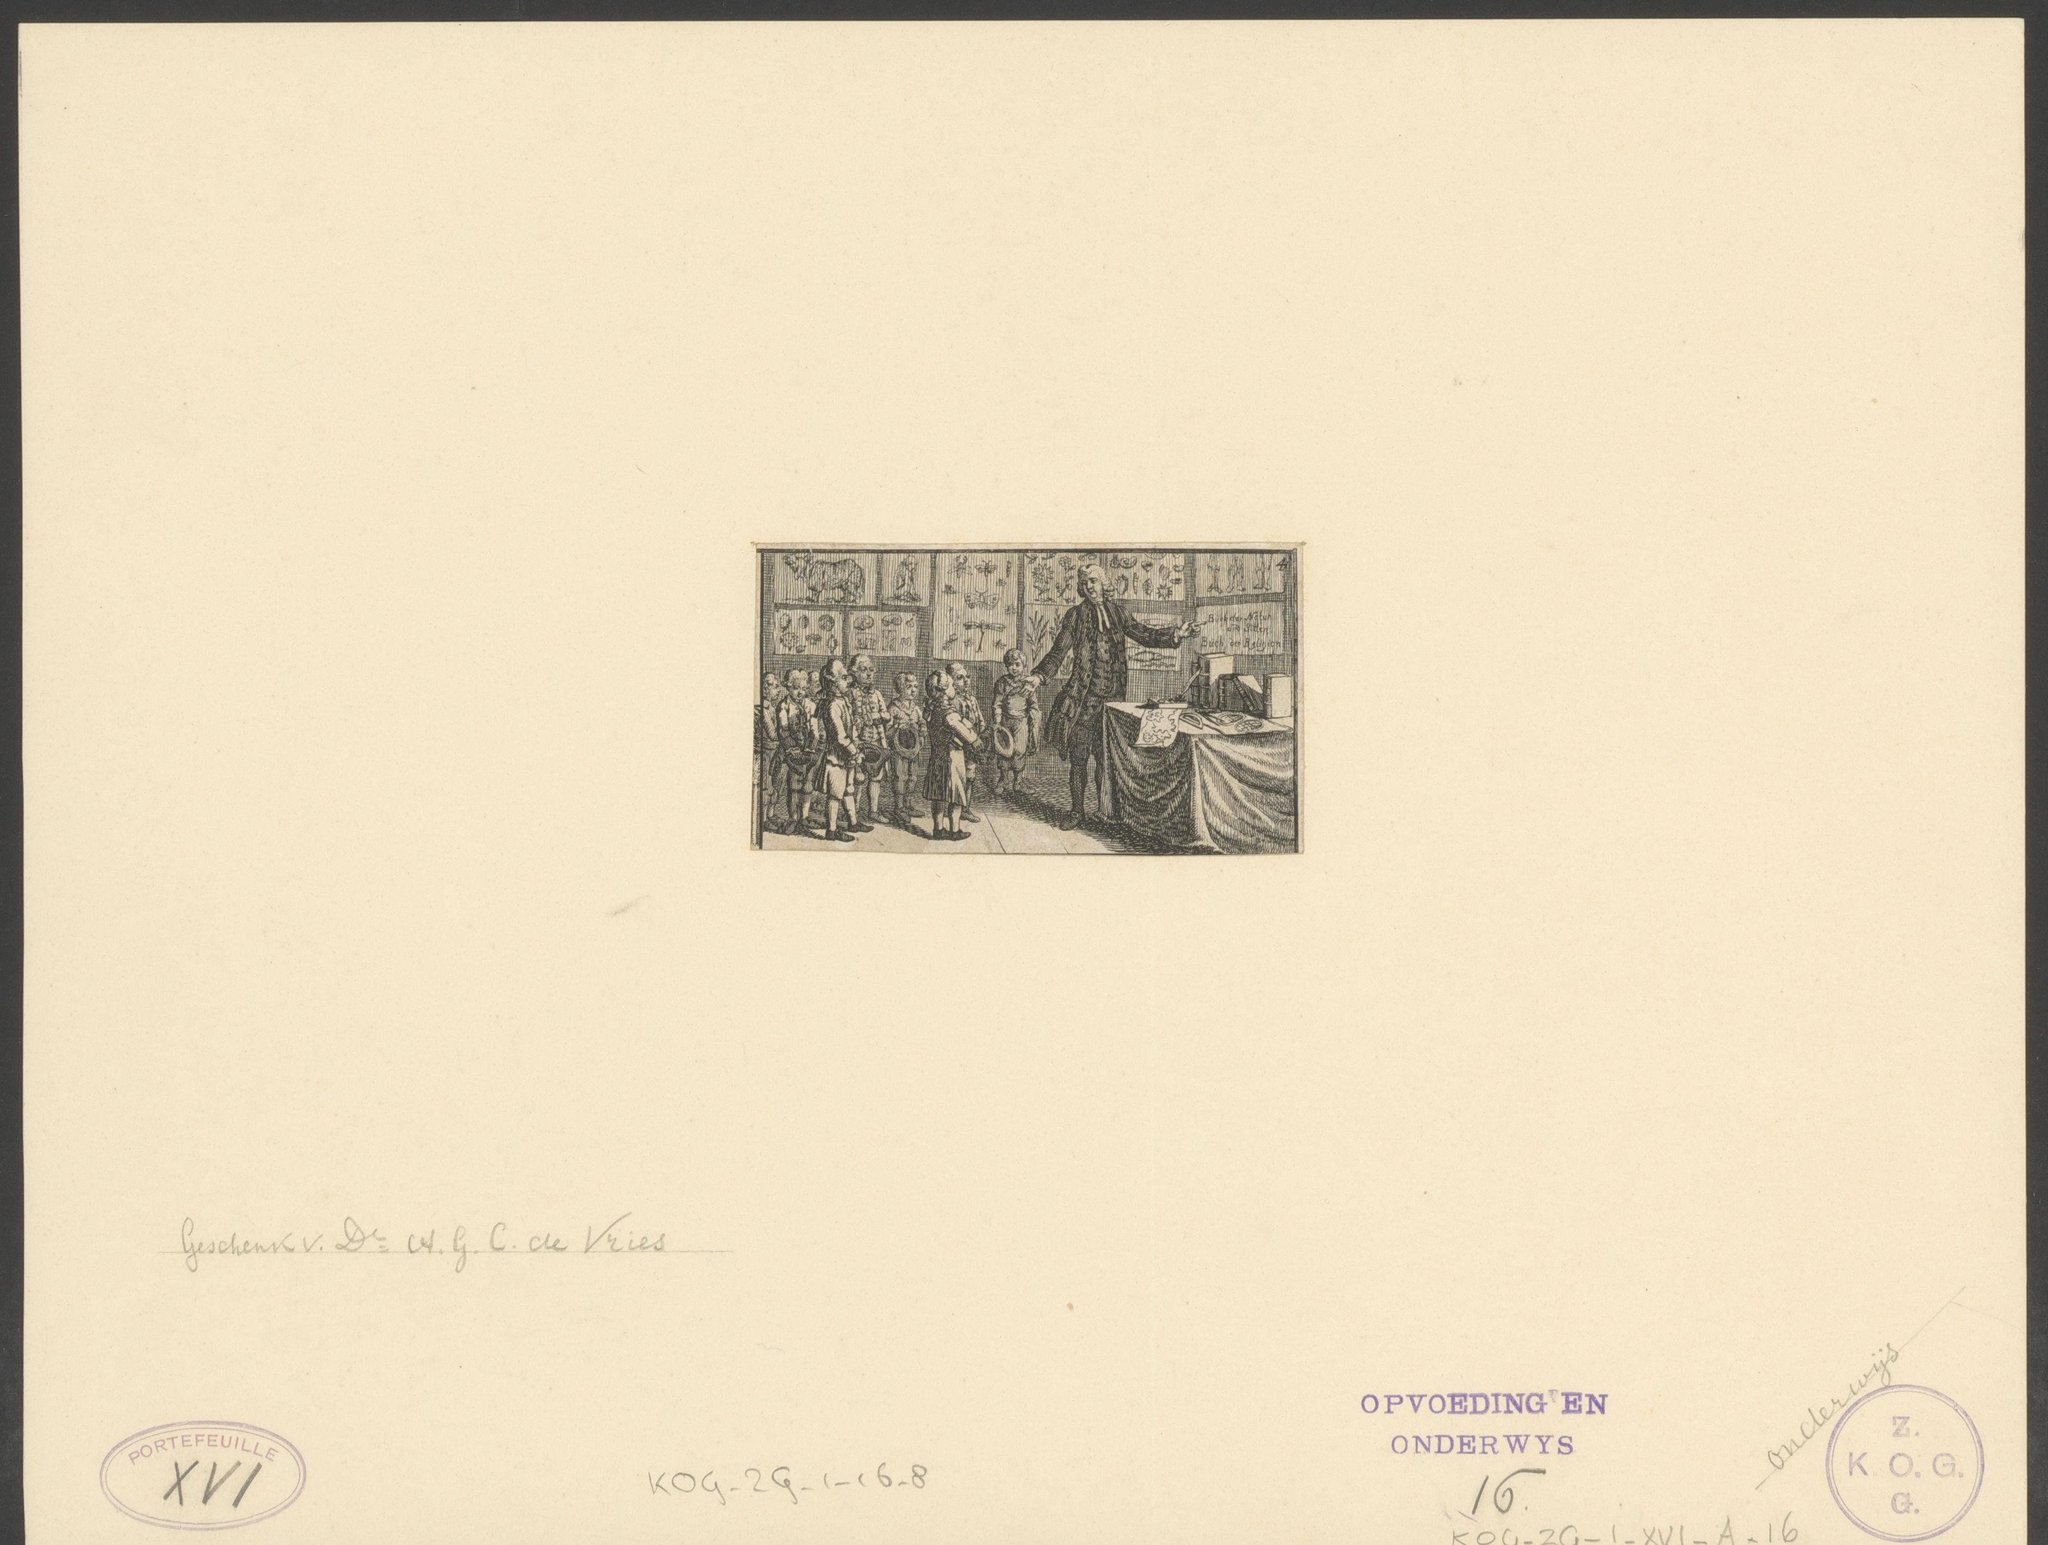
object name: print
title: Schoolmeester tijdens de les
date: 1770-1849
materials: paper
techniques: etching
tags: bookshelves, scholar in his study, planimetry, geometry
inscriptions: collector's mark: Lugt 1641, stamp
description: De leraar wijst naar een bord met 'Büch der Natur und Sitten. Buch der Religion'. Onderwerpsrubrieken binnen de Atlas Zeden en Gewoonten: Onderwijs en Wetenschappen, Opvoeding en Onderwijs, Schoolmeesters.